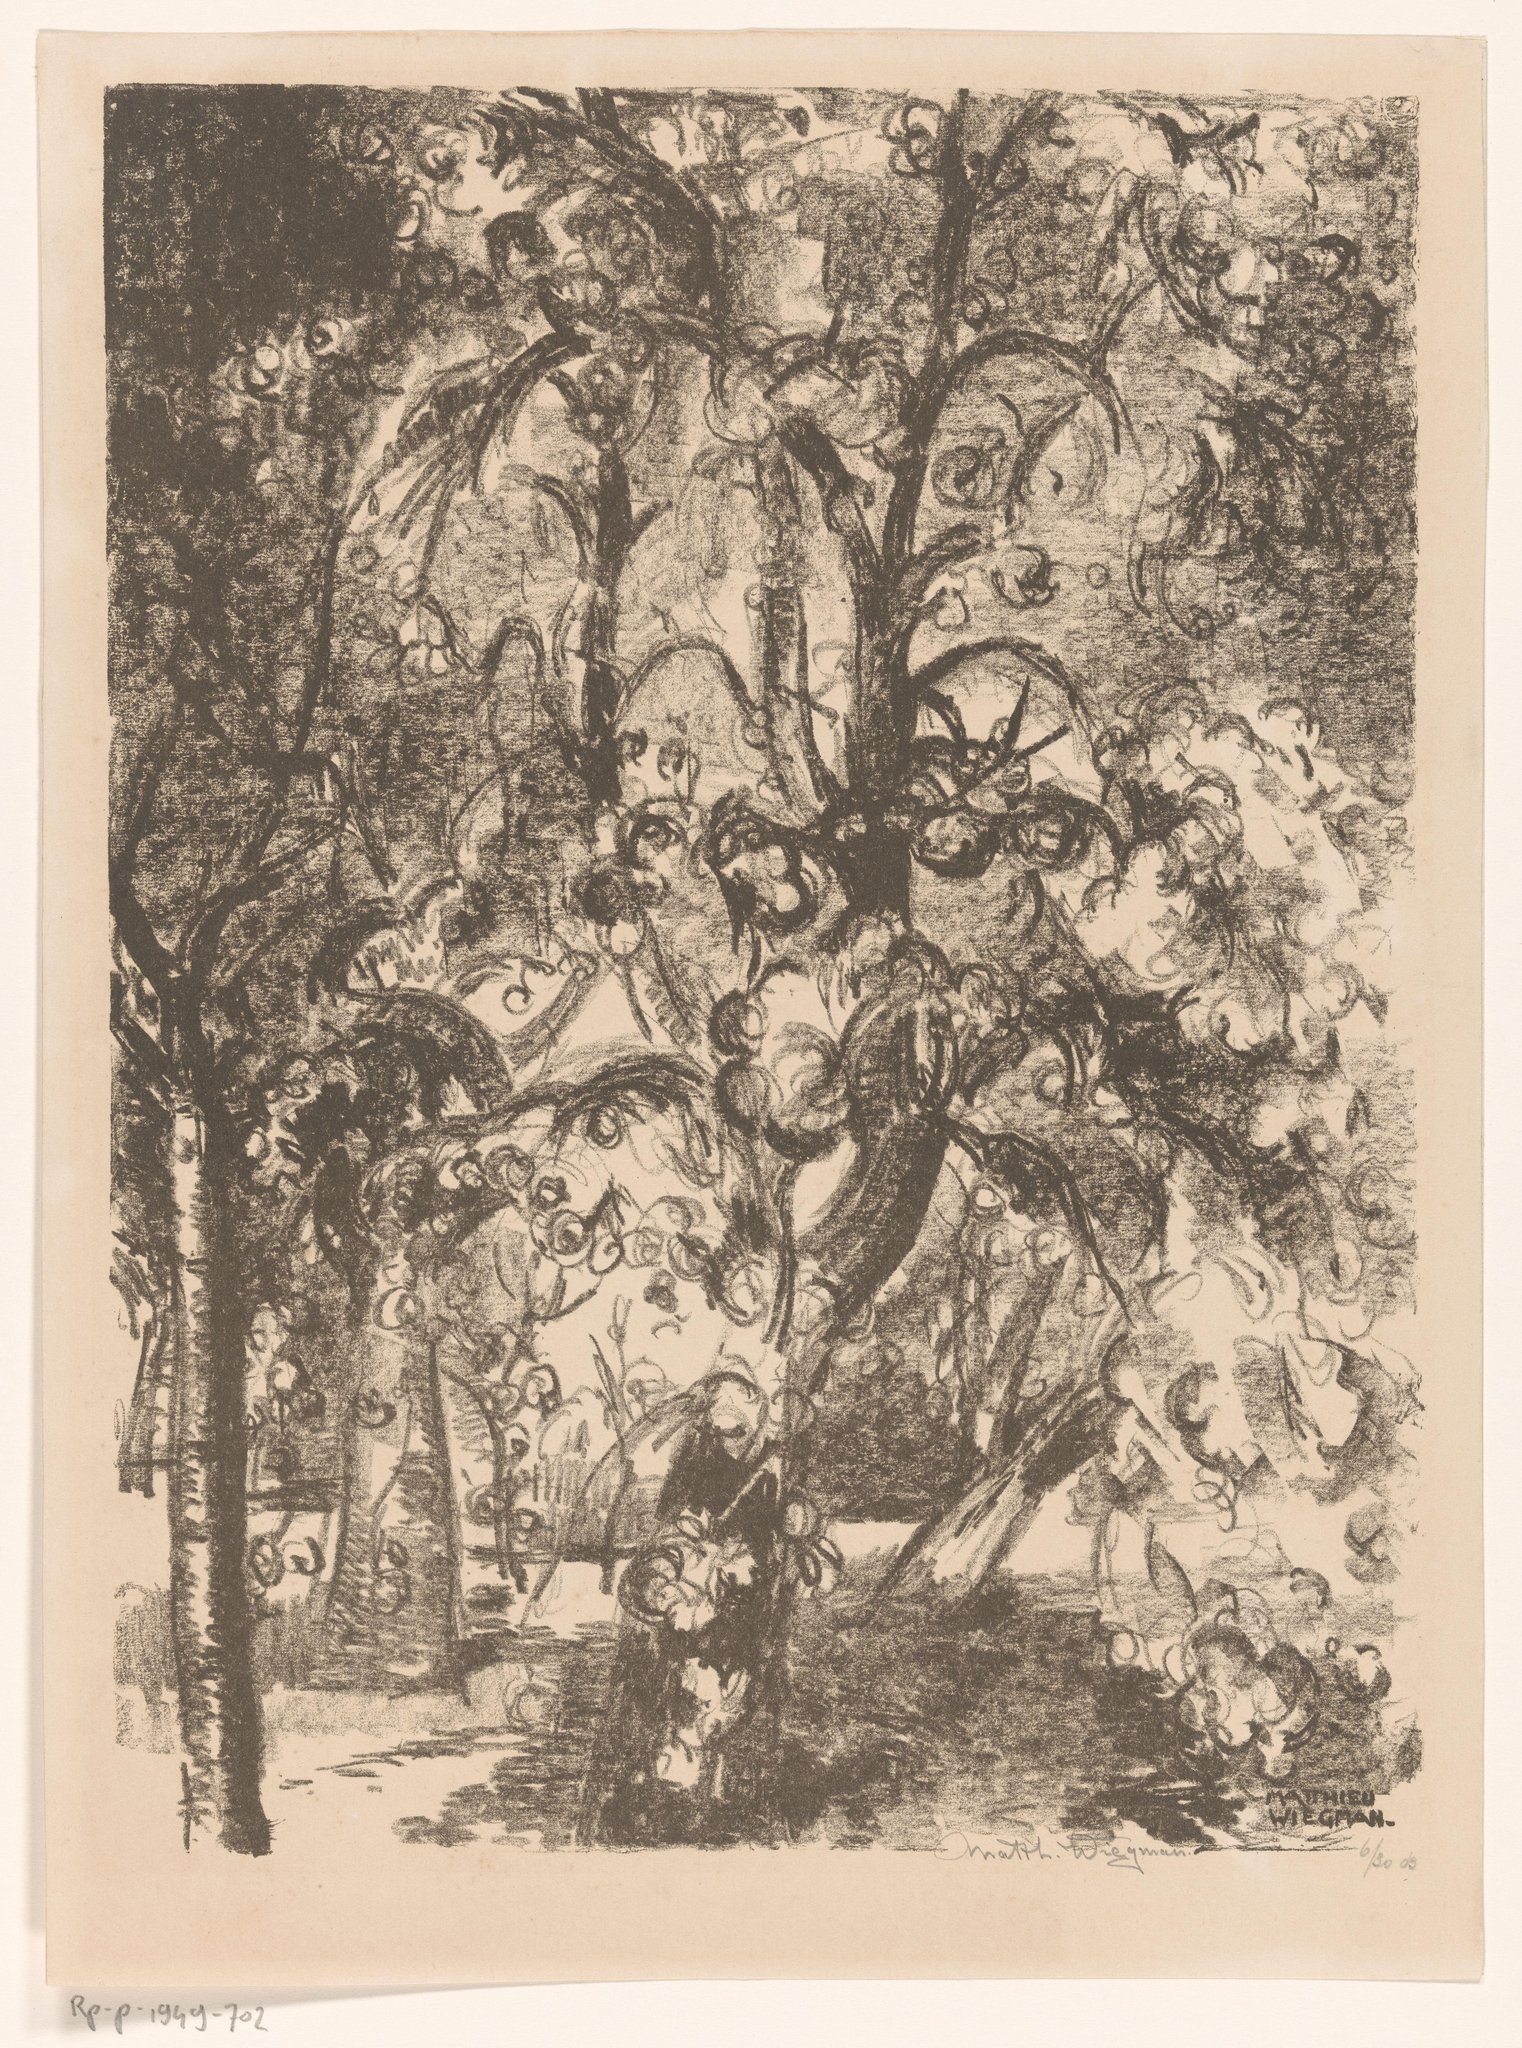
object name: print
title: Bloeiende boomgaard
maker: matthieu wiegman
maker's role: print maker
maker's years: 1886-1971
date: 1909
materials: paper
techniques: lithograph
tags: trees, orchard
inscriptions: collector's mark: Lugt 2760, collector's mark: Lugt 2228